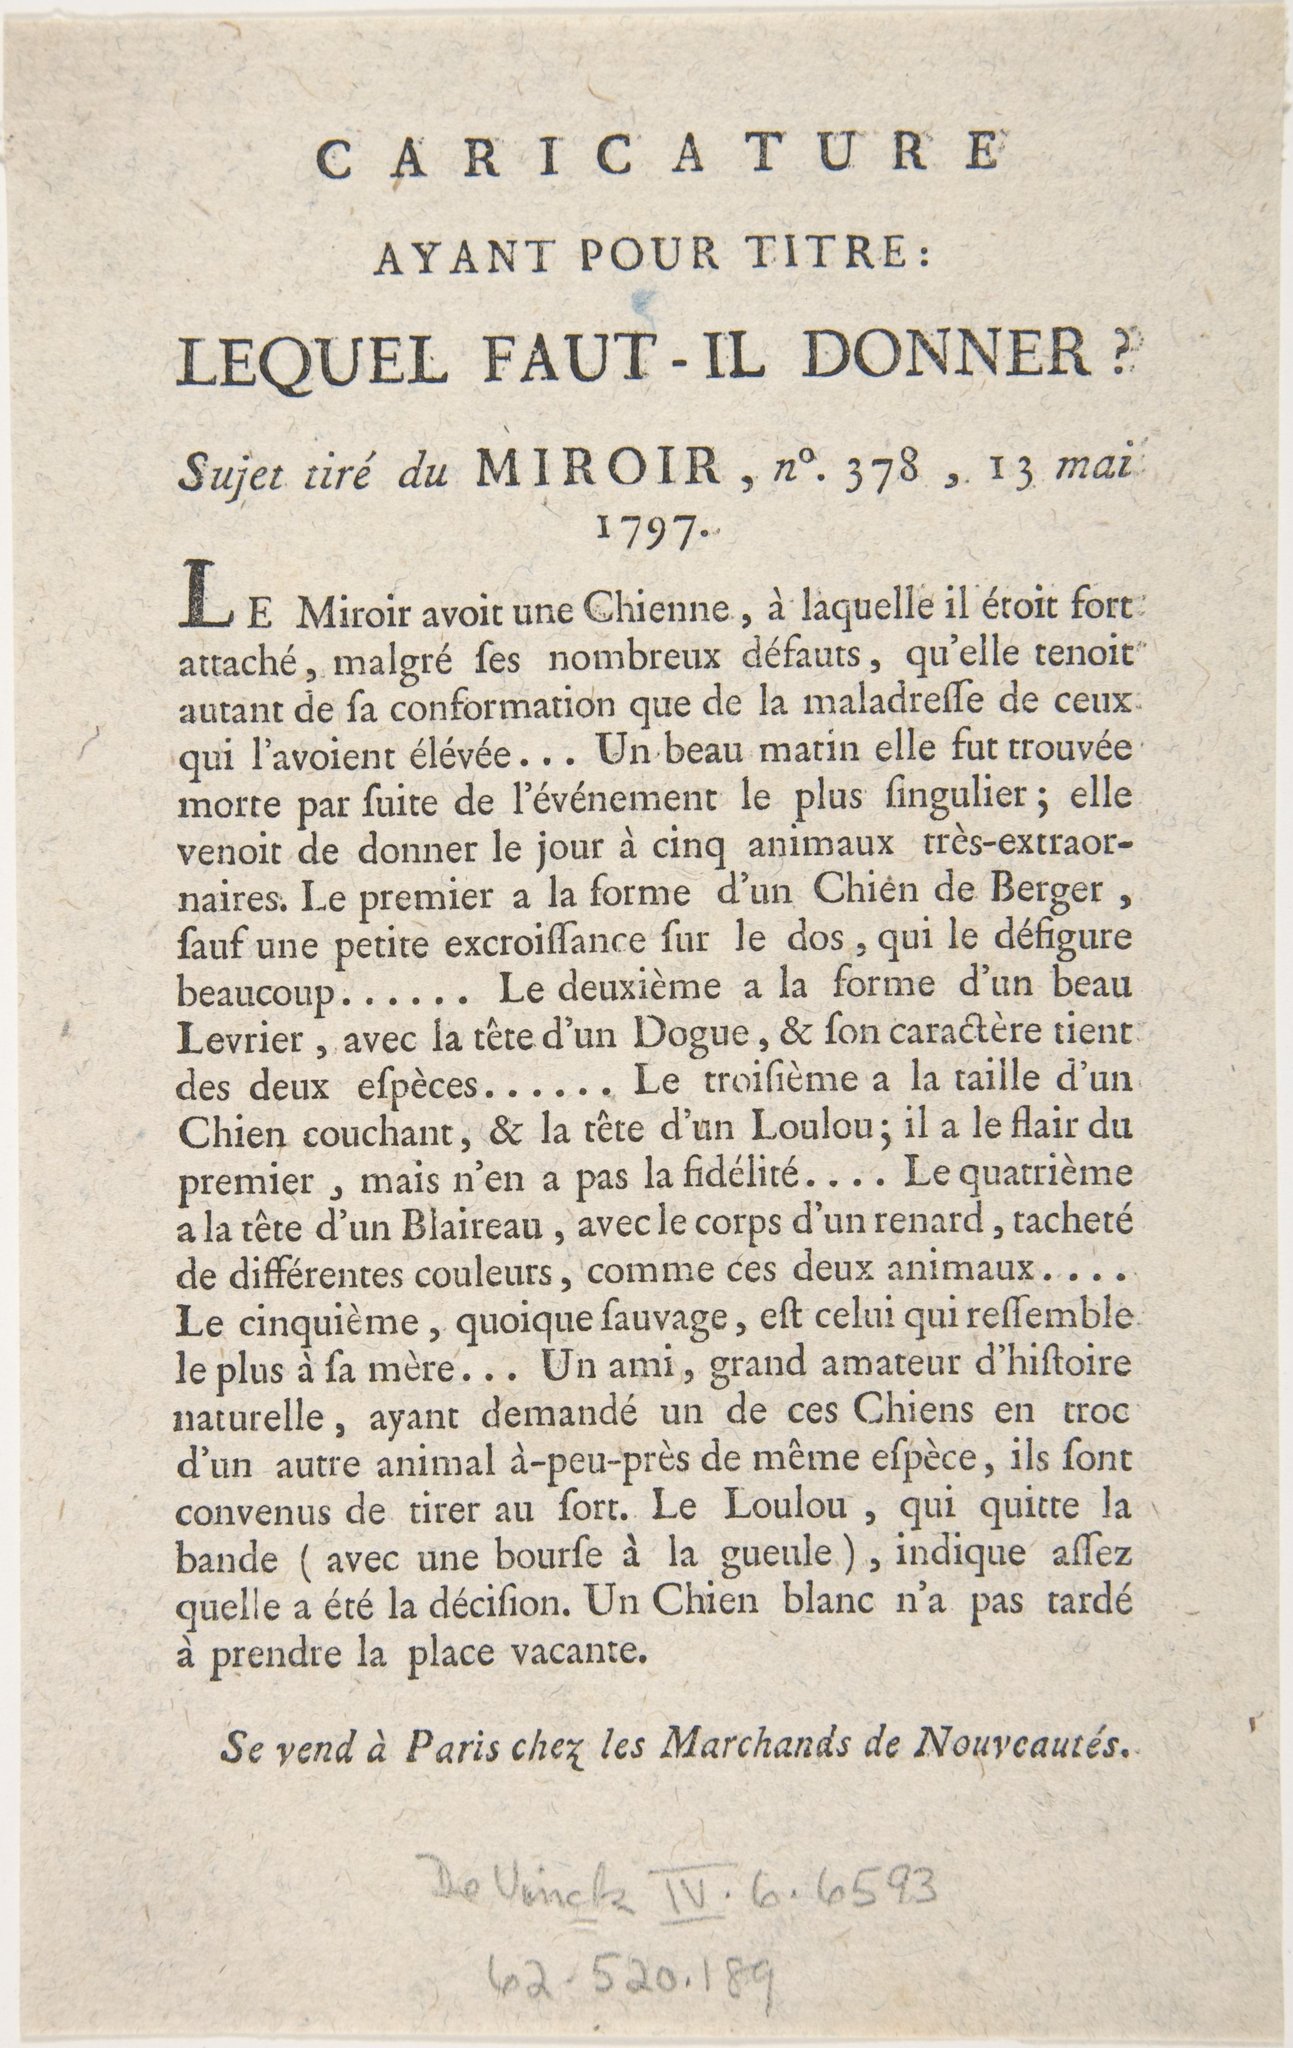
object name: print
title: Caricature, Ayant Pour Titre: Lequel Faut-il Donner?, Sujet tiré du Miroir, no. 378, 13 Mai, 1797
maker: anonymous, french, 18th century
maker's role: author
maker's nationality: french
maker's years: 1700-1800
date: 1797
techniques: letterpress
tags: french revolution